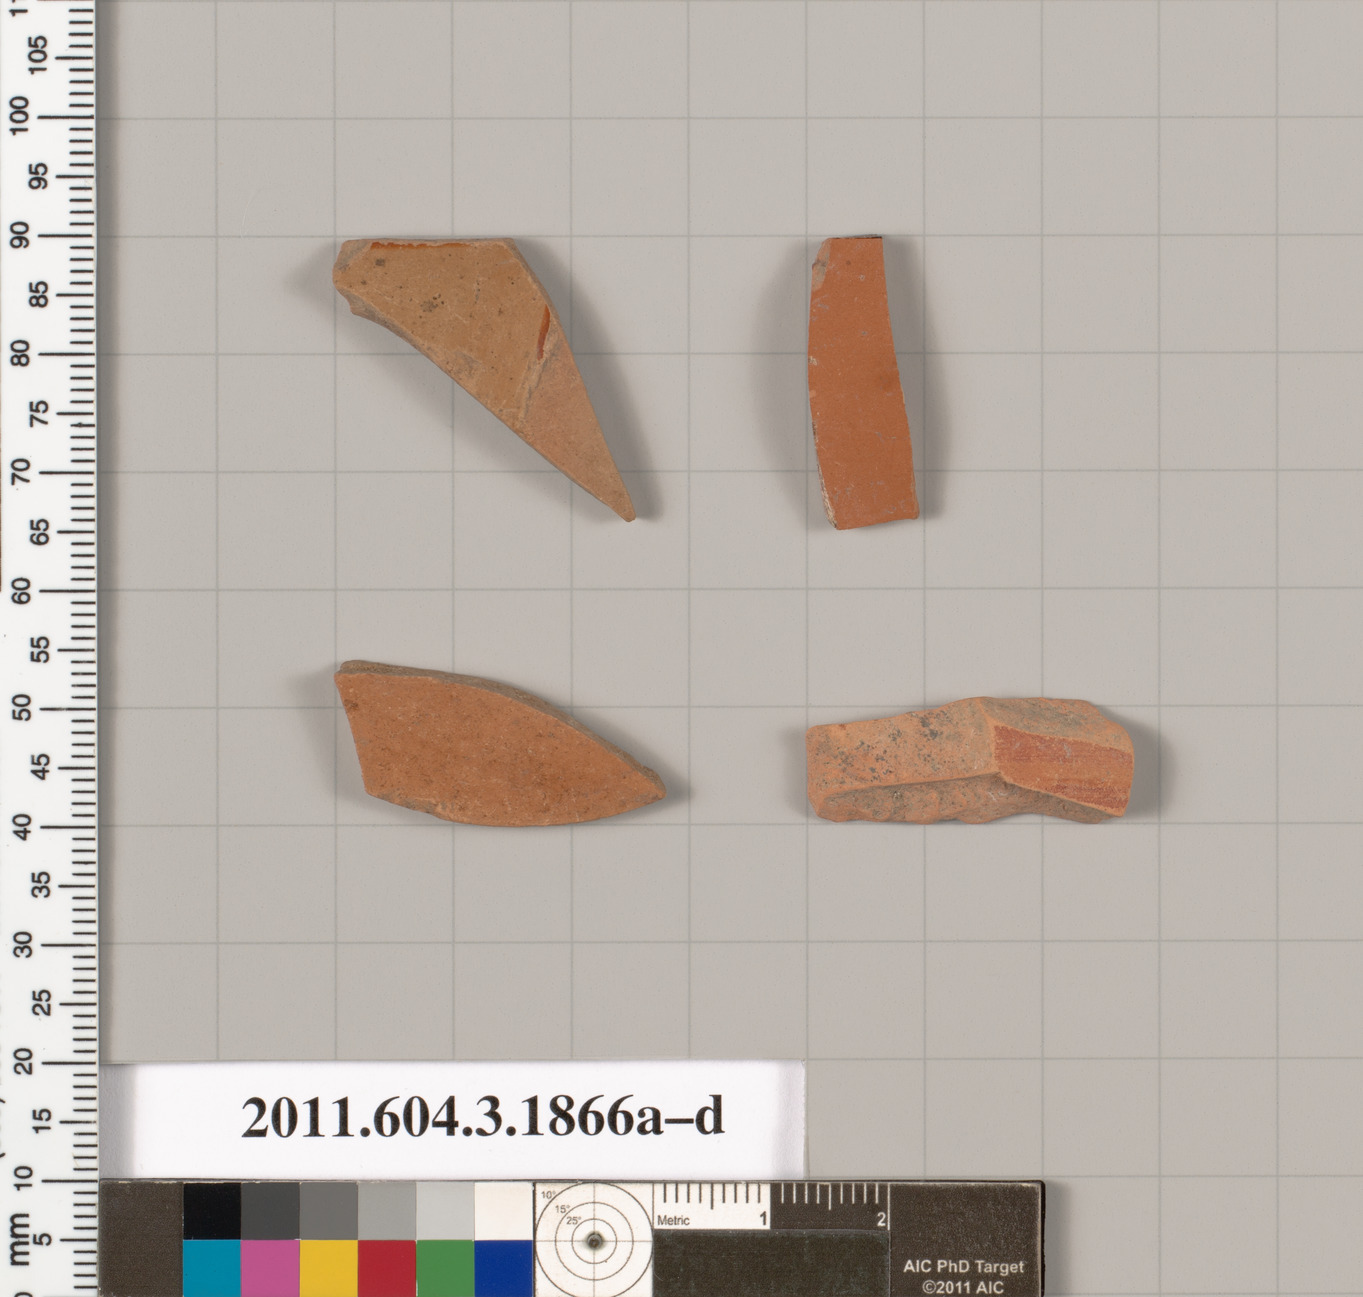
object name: kylix fragment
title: Terracotta fragments of kylikes: Band or lip cups (drinking cups)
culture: greek, attic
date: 560-525 BCE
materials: terracotta